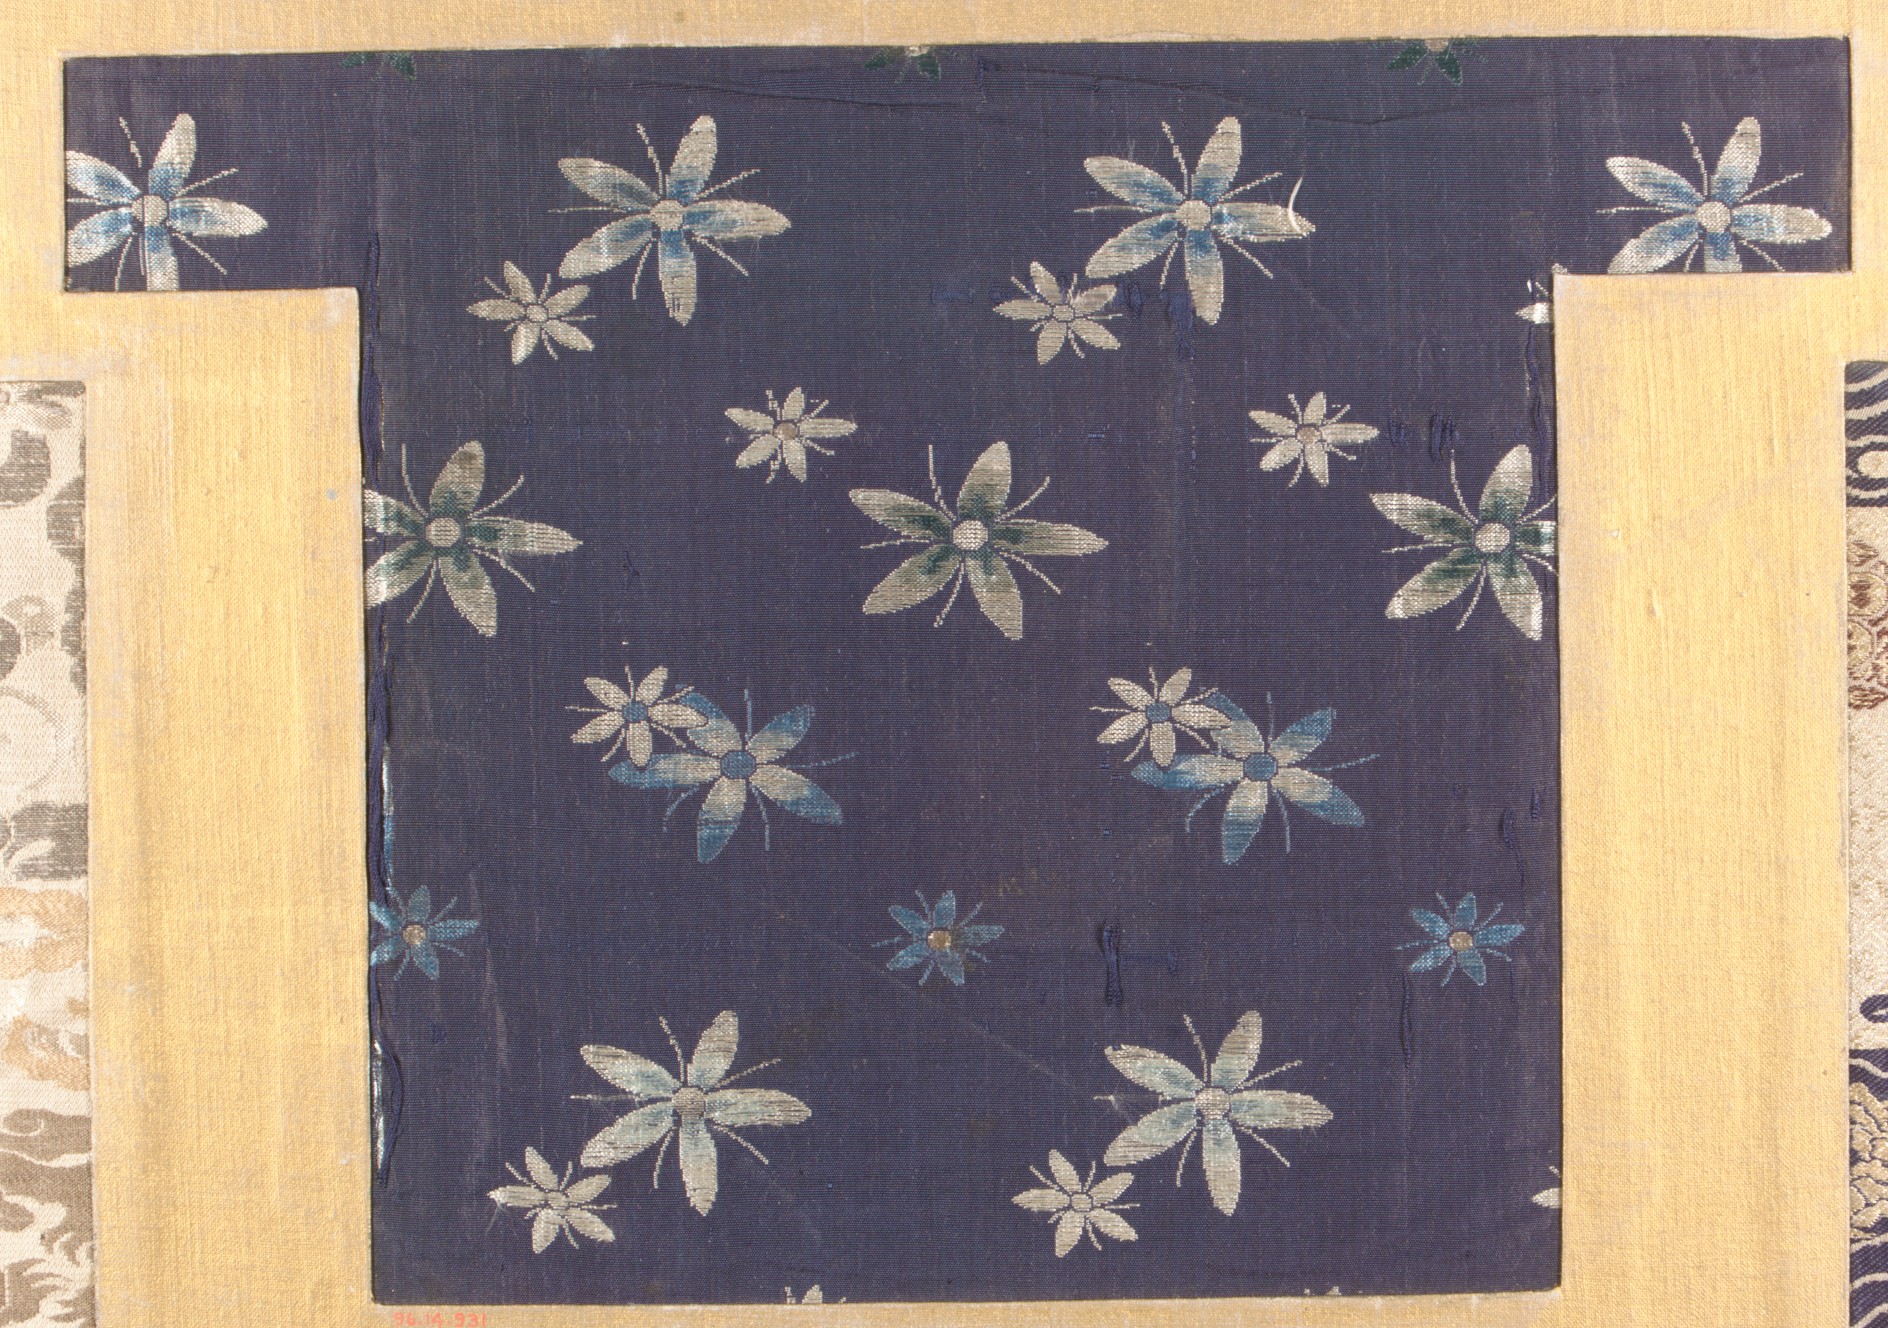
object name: piece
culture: japanese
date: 1701-1900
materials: silk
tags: flowers